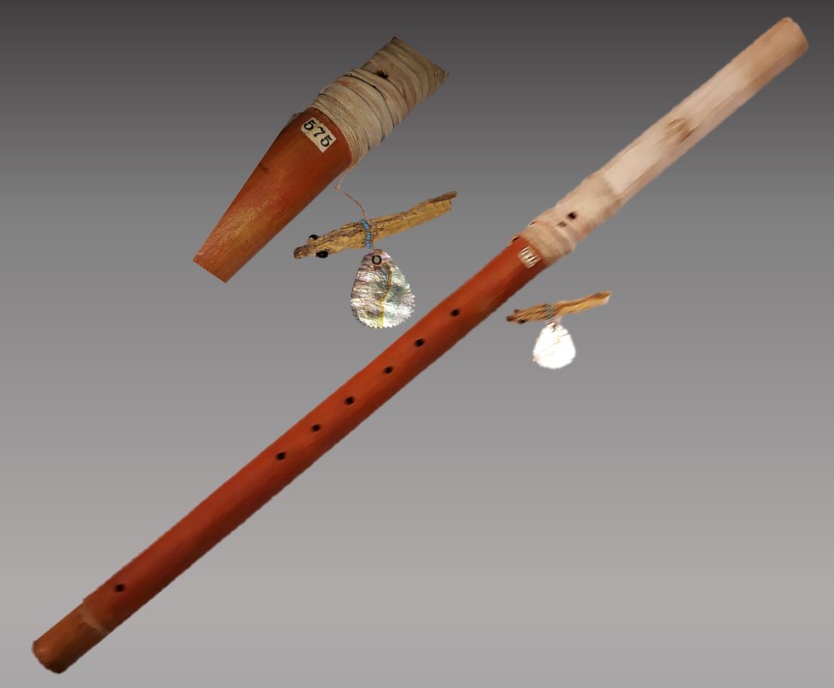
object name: flute end blown flute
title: Flute (end blown flute)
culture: native american, apache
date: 1801-1900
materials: shell, skin, wood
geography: united states